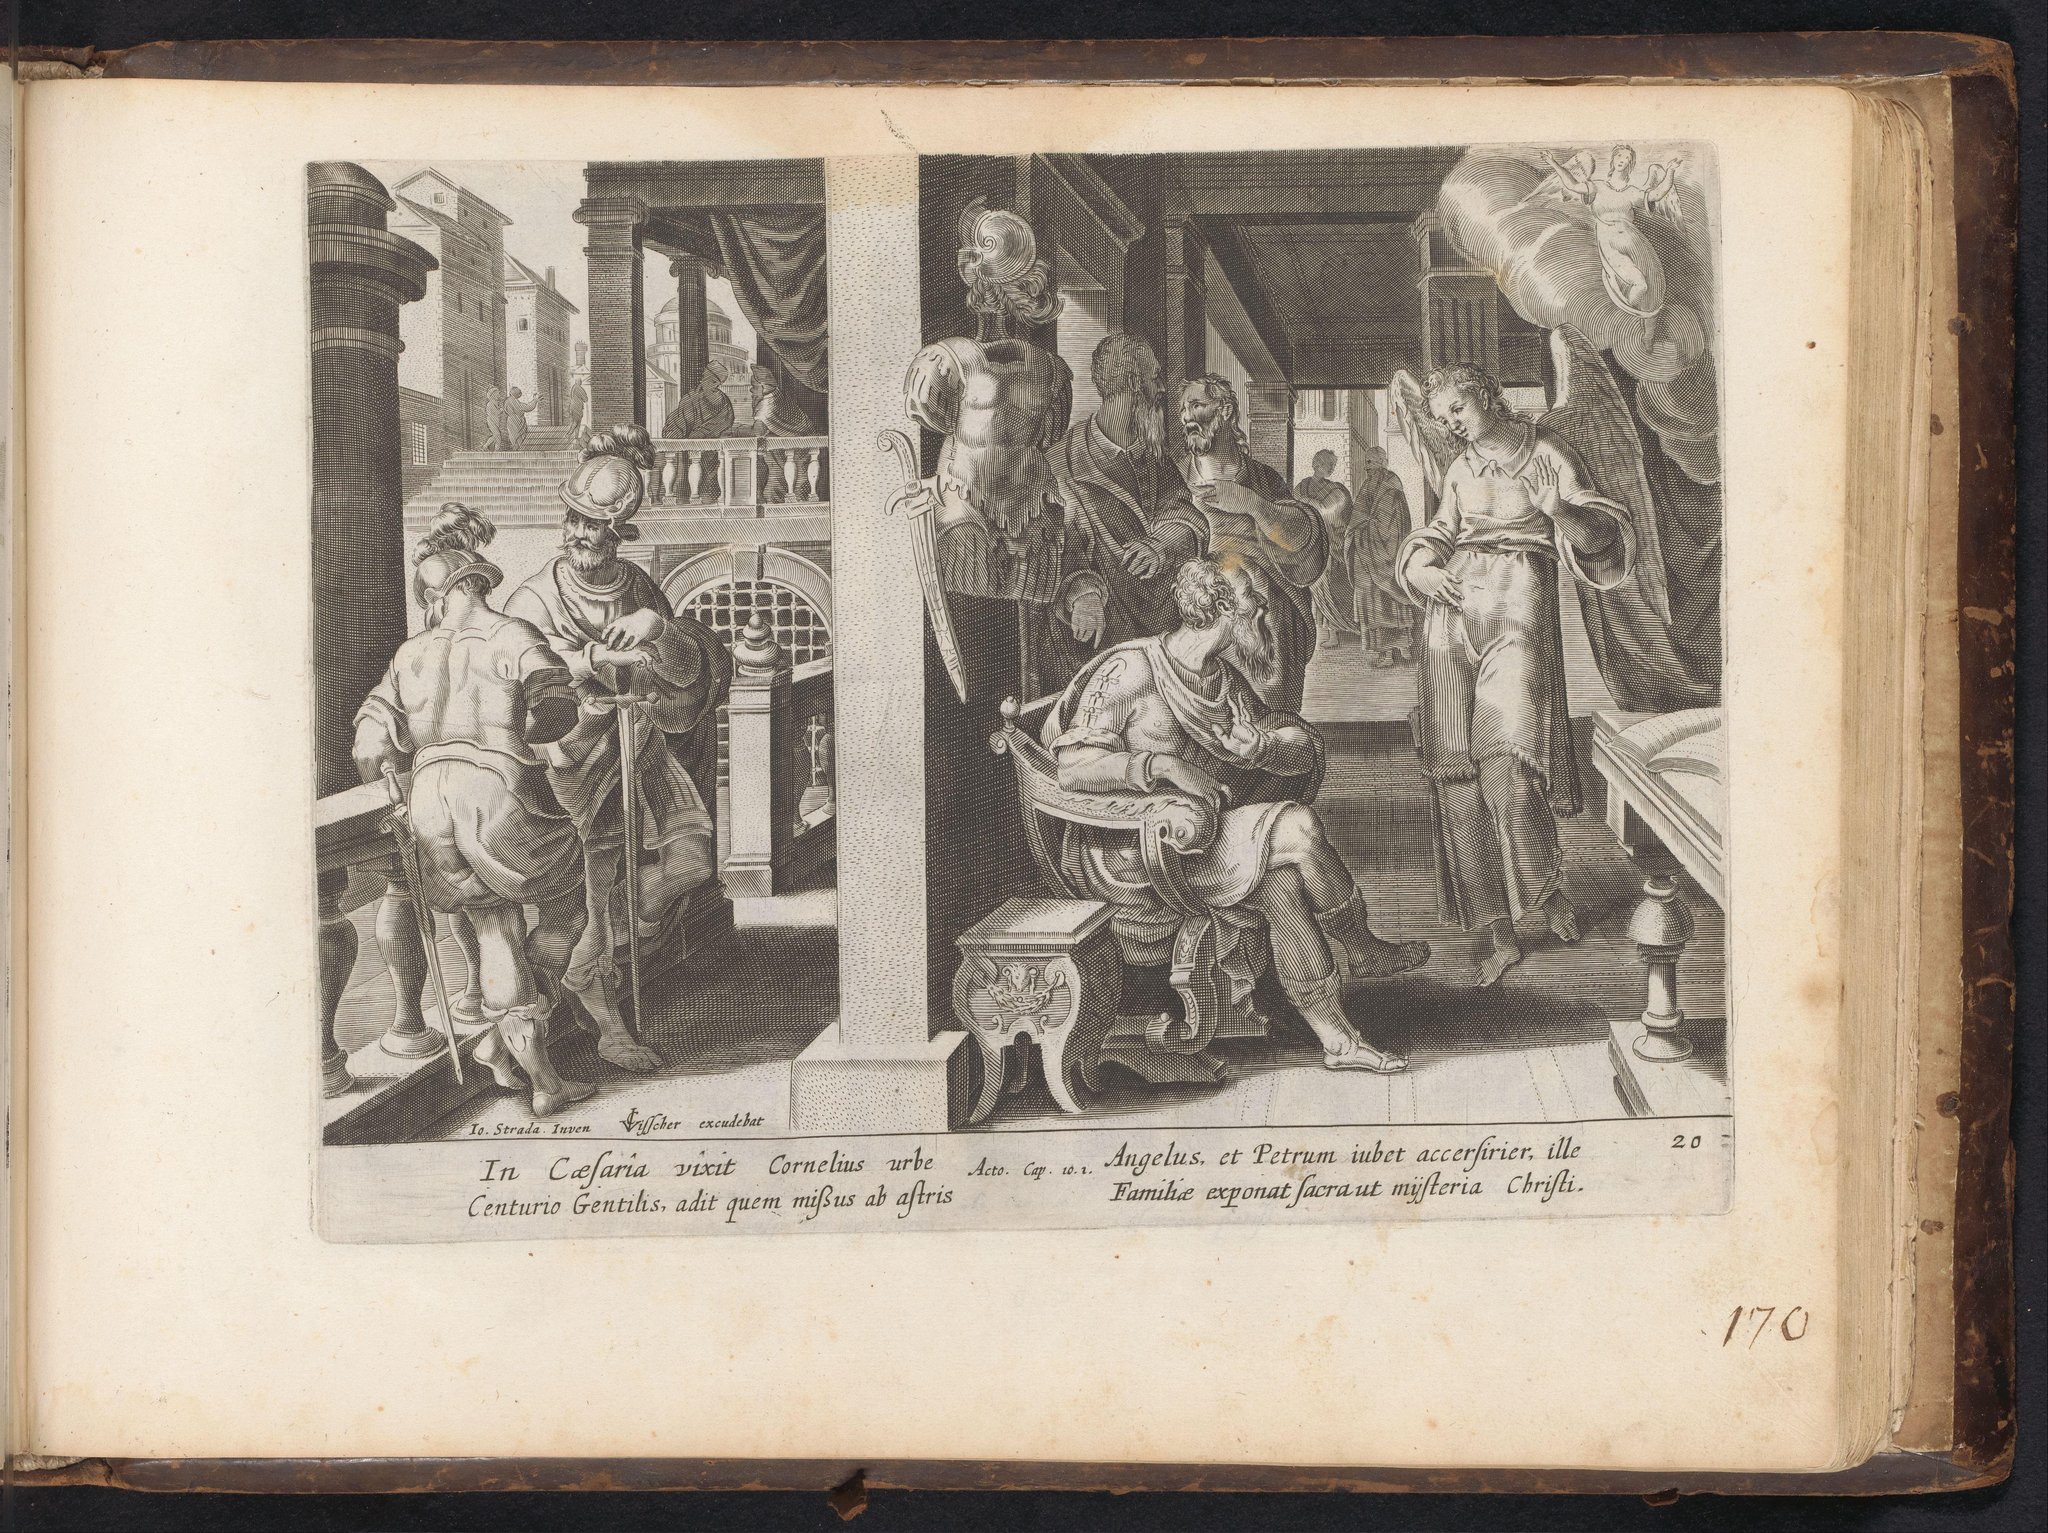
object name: print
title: Visioen van Cornelius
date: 1643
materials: paper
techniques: engraving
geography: amsterdam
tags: cornelius sends two servants and a soldier to peter in joppa, cornelius the centurion and the angel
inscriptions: number: ‘170’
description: Een engel verschijnt voor Cornelius in een visioen. Hij beveelt hem de apostel Petrus uit Joppe te laten halen. Twee soldaten worden eropuit gestuurd om Petrus te halen. Onder de voorstelling een verwijzing in het Latijn naar de Bijbeltekst in Hand. 10:1. Deze prent maakt deel uit van een album.